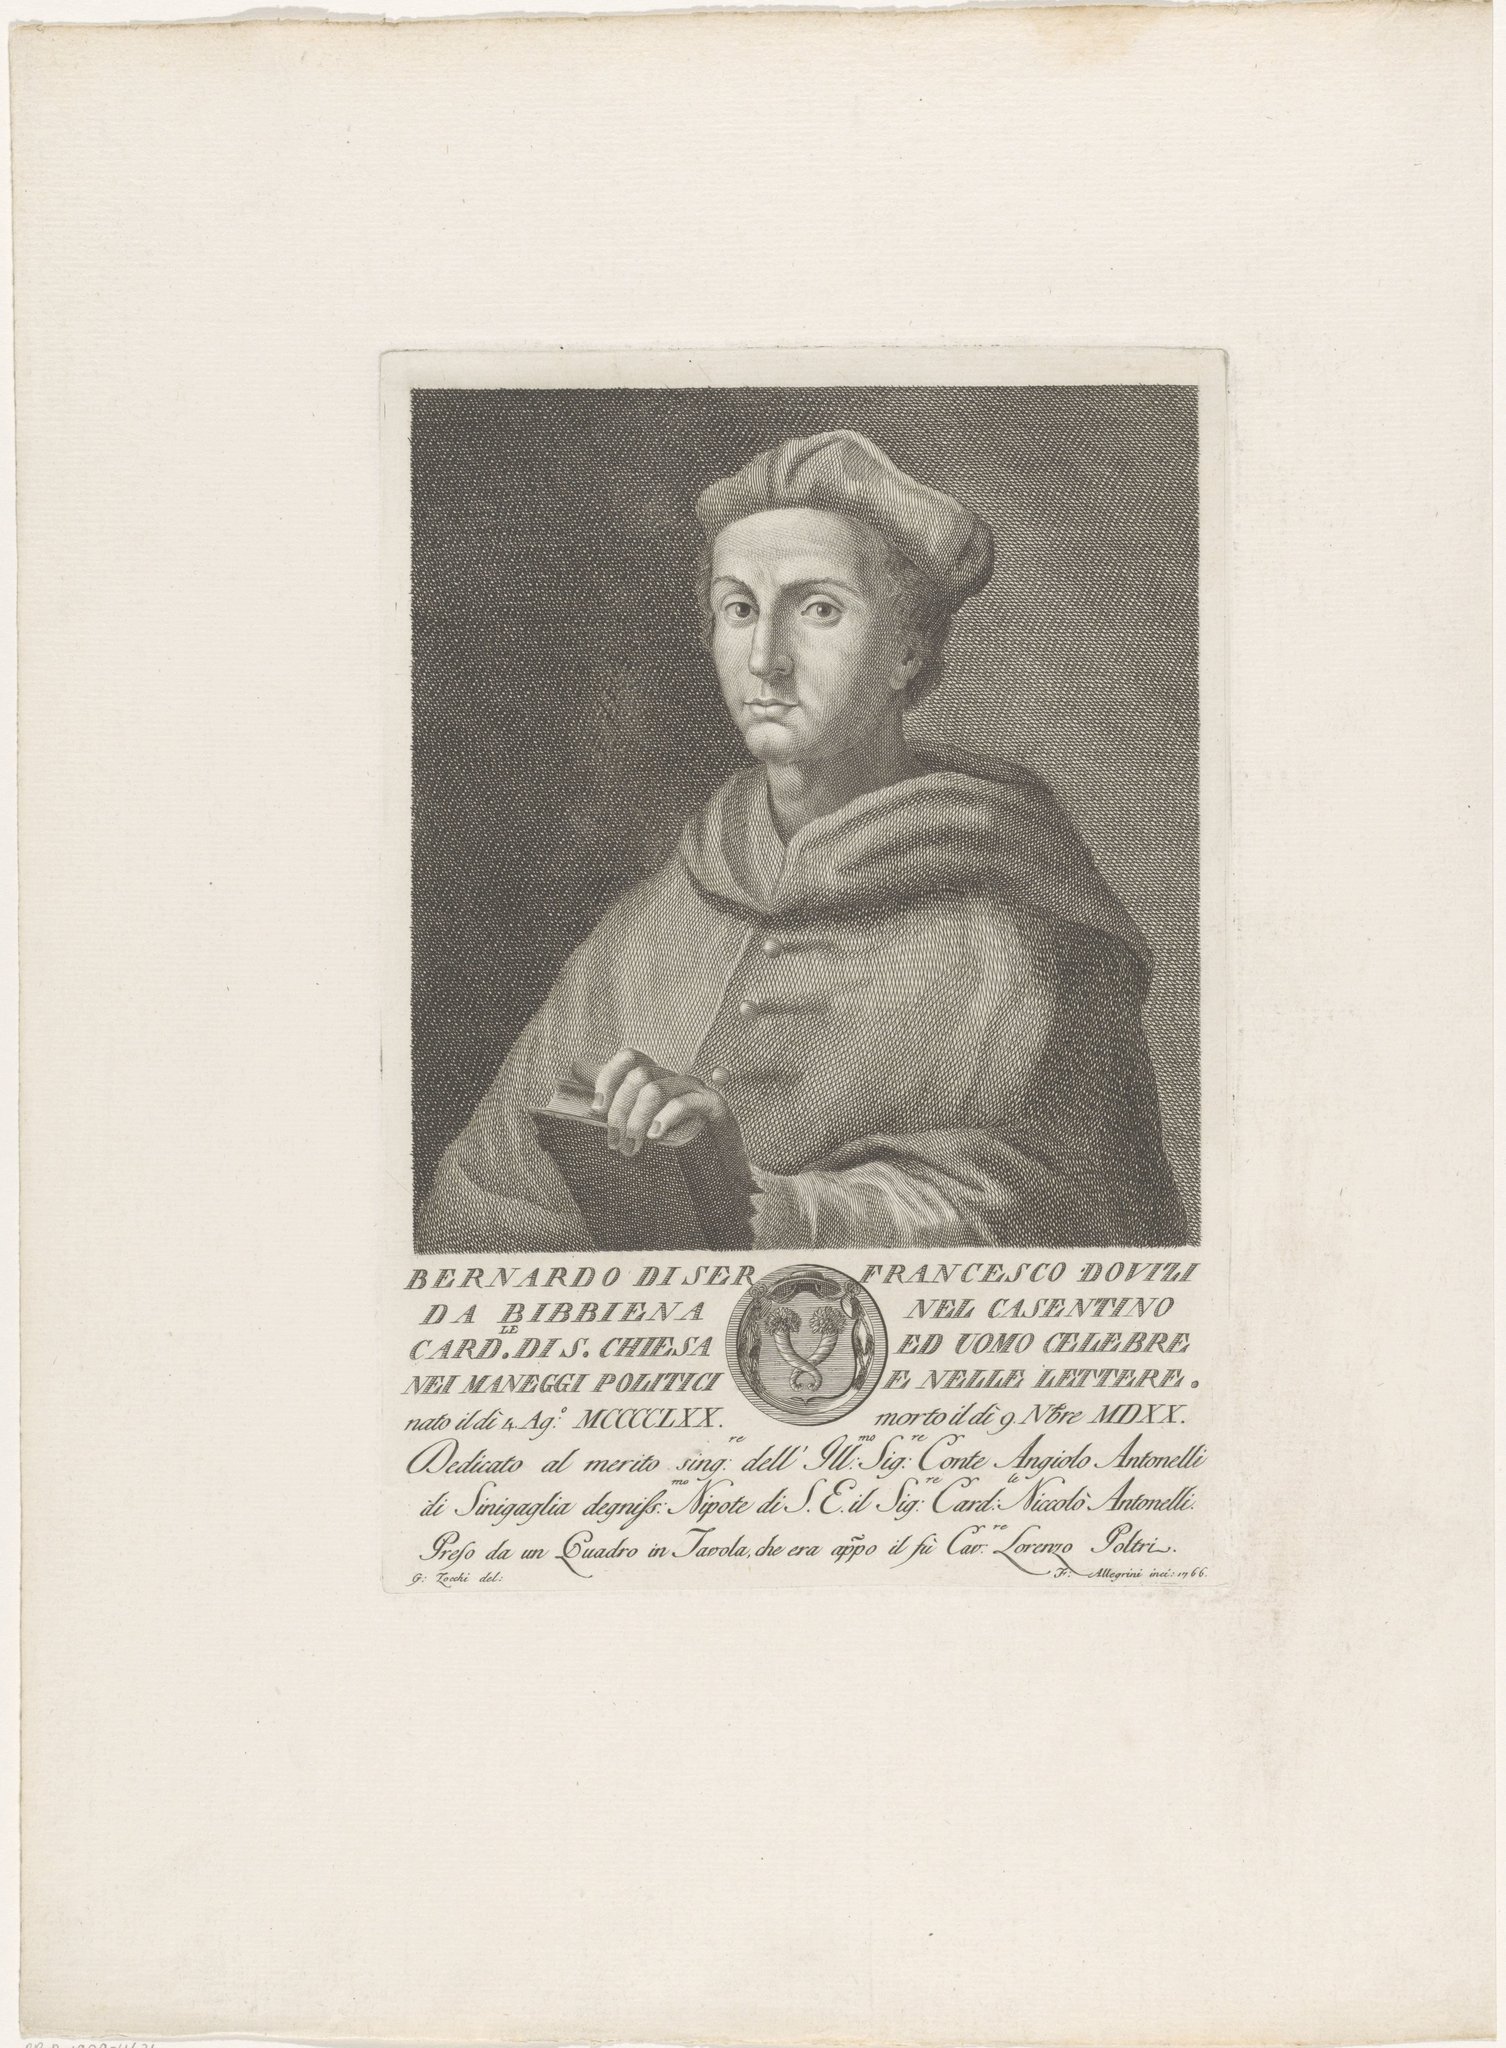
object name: print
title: Portret van Bernardo Dovizi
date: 1766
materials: paper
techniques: engraving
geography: italy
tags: historical persons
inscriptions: collector's mark: Lugt 2228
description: Deze prent maakt deel uit van een reeks portretprenten van onbekende omvang. De prenten zijn gemaakt door meedere prentmakers, onder wie Francesco Allegrini en Carlo en Raimondo Faucci.